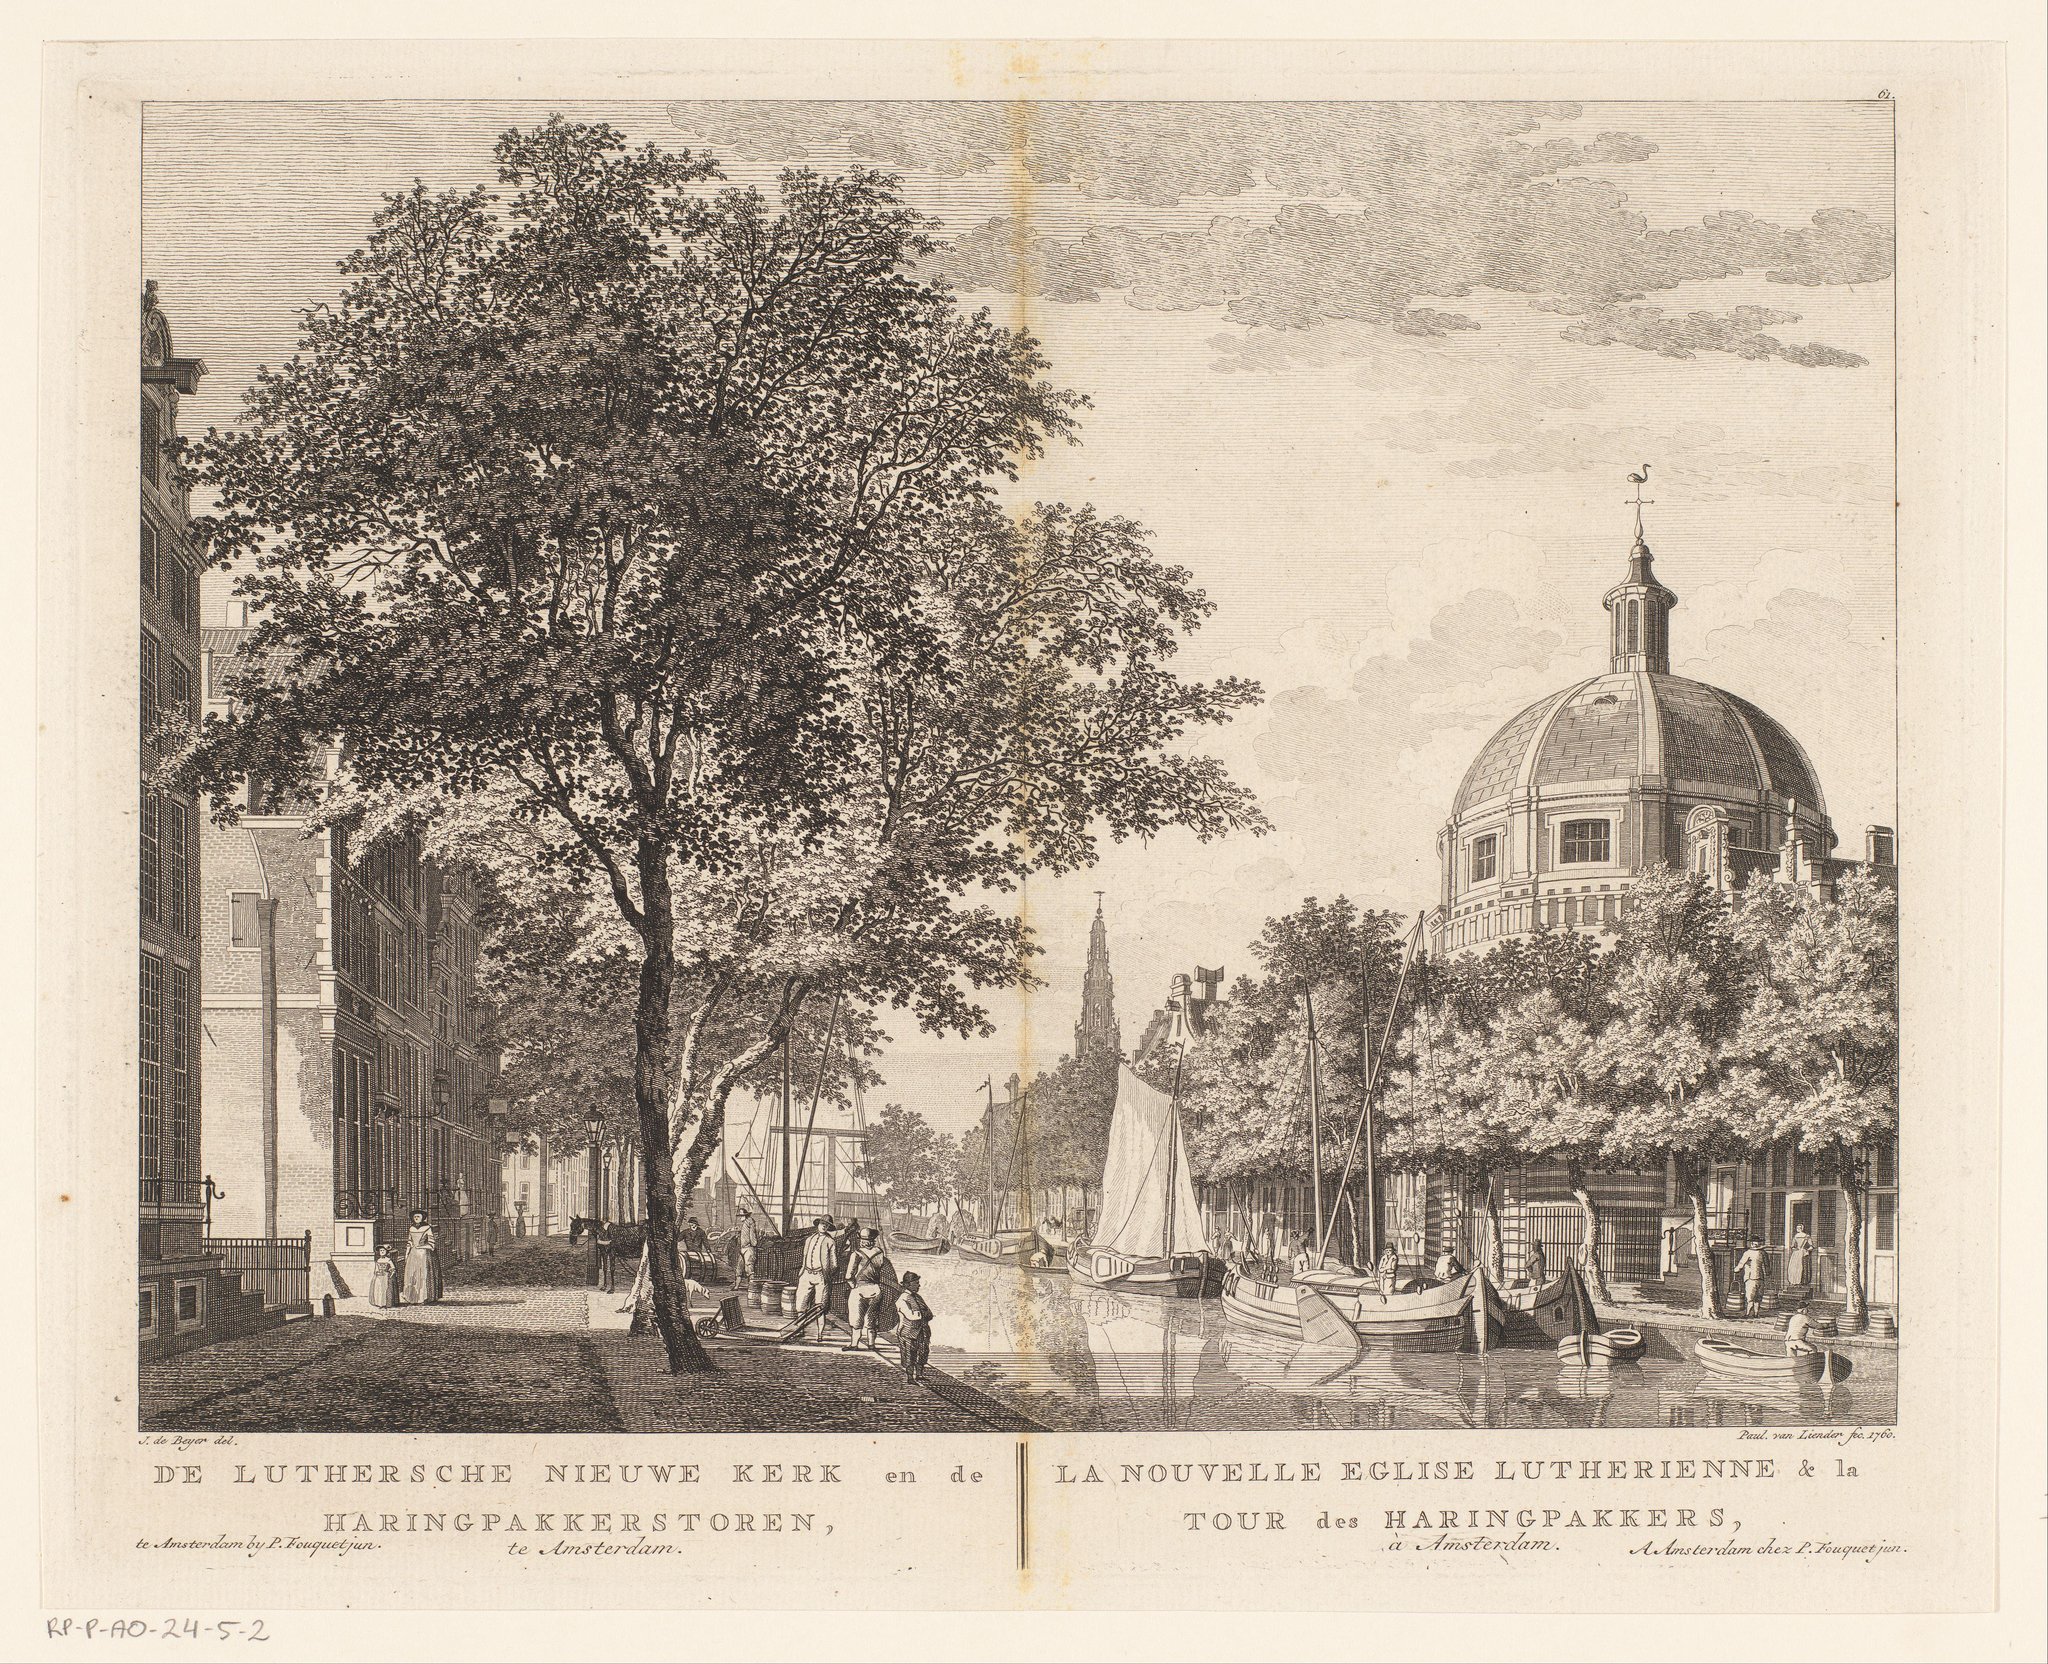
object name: print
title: Gezicht op de Ronde Lutherse Kerk te Amsterdam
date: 1760-1783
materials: paper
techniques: engraving, etching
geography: amsterdam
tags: protestant churches and denominations (lutherans), towers ~ fortified city, church (exterior), canals, waters (in city) (+ city(-scape) with figures, staffage), street (+ city(-scape) with figures, staffage)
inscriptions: collector's mark: Lugt 2233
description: Deze prent is ook gebruikt in de zogenaamde Atlas van Fouquet.* Pierre Fouquet gaf vanaf 1760 stadsgezichten van Amsterdam - naar tekeningen van verschillende kunstenaars, gemaakt door verschillende prentmakers - uit. Deze prenten werden aanvankelijk los of in series verkocht. Zoals toen gebruikelijk kon de koper de prenten zelf laten inbinden. Hiertoe gaf Fouquet tussen 1778 en 1783 een titelblad, plattegrond en inhoudsopgave van de tot dusver 100 uitgegeven prenten uit (1). Gezien de inhoud afhankelijk was van wat de koper had verzameld verschilt de inhoud van de verschillende bewaarde Fouquetatlassen onder deze titel sterk. Ook zijn er exemplaren bekend waar tevens andere prenten aan zijn toegevoegd. Omdat er behoefte bleek aan uitleg bij de platen werd in 1783 een nieuwe versie van de atlas uitgegeven, aangevuld met tekst en twee prenten. De aangegeven volgorde veranderde maar de platen van de al eerder uitgegeven prenten bleven ongewijzigd. Deze uitgave werd in opdracht van Fouquet gedrukt bij Daniël Jean Changuion en Petrus den Hengst (2). Een tiental platen werd bijgewerkt en verscheen, met nieuw impressum, in het vervolg van Wagenaars geschiedenis van Amsterdam, uitgeven door Petrus Conradi en Folkert van der Plaats (3). Een aantal jaar na het overlijden van Fouquet kwam Evert Maaskamp met een nieuwe uitgave van de atlas, met verbeterde tekst en toevoeging van twee prenten. Op alle platen verwijderde hij het oude en liet hij zijn eigen impressum zetten (4). De huidige staat van de prent komt voor in exemplaren van de onder (1) en (2) genoemde werken. * Onder de Atlas van Fouquet of Fouquetatlas verstaan we de hieronder vermelde publicaties (1), (2) en (4). (1). Afbeeldingen van de wyd-vermaarde koopstad Amsterdam benevens des zelvs voornaamste gebouwen en gezigten alle naar het leeven getekend / Receuil des edifices les plus considerables et des plus belles vues, de la fameuse ville d'Amsterdam, dessinées d'après nature. Amsterdam: Pierre Fouquet, 1778-1783. (2). Nieuwe atlas, van de voornaamste gebouwen en gezigten der stad Amsterdam, met derzelver beknopte beschryvingen. 2 delen. Amsterdam: Daniël Jean Changuion en Petrus den Hengst [in opdracht van Pierre Fouquet], 1783. (3). Stijl, Simon. Amsterdam, in zyne geschiedenissen, voorregten, koophandel, gebouwen, kerkenstaat, schoolen, schutterye, gilden en regeeringe, beschreeven. Om te dienen ten vervolge op het werk van Jan Wagenaar (…). 10 delen. Amsterdam en Harlingen: Petrus Conradi en Folkert van der Plaats, 1788-1801. (4). Nieuwe atlas, van de voornaamste gebouwen en gezigten der stad Amsterdam. Met derzelver beknopte beschryvingen. Amsterdam: Evert Maaskamp, 1805. * Het aantal vermelde staten is gebaseerd op het aantal gevonden staten. Mogelijk zijn er meer staten van deze prent. Voor eerste bekende staat zie RP-P-AO-24-5-1. Voor vierde bekende staat zie RP-P-OB-46.352